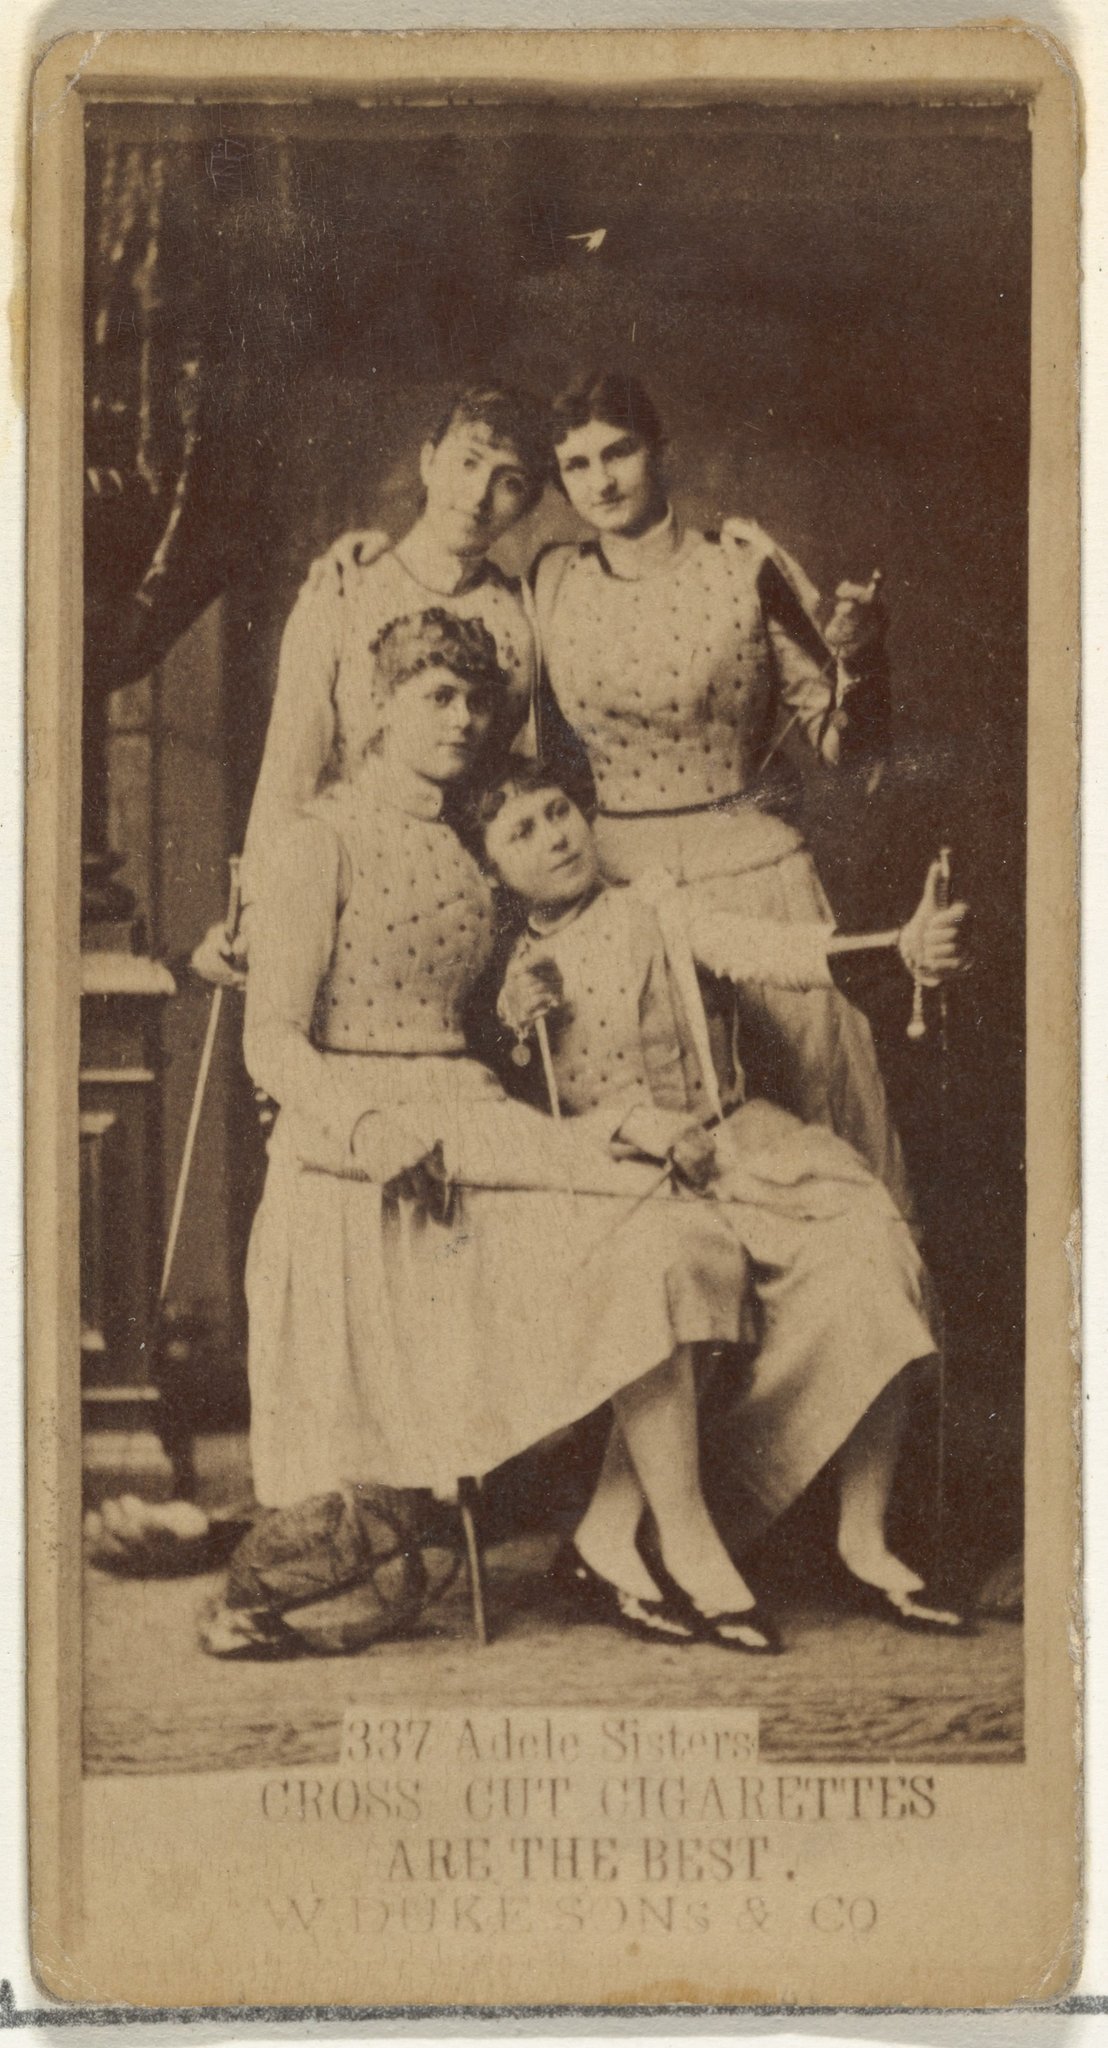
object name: photograph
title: Card Number 337, Adele Sisters, from the Actors and Actresses series (N145-3) issued by Duke Sons & Co. to promote Cross Cut Cigarettes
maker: w. duke, sons & co.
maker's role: publisher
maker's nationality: american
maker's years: 1870-1920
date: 1880-1889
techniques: albumen silver print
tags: girls,women,actresses